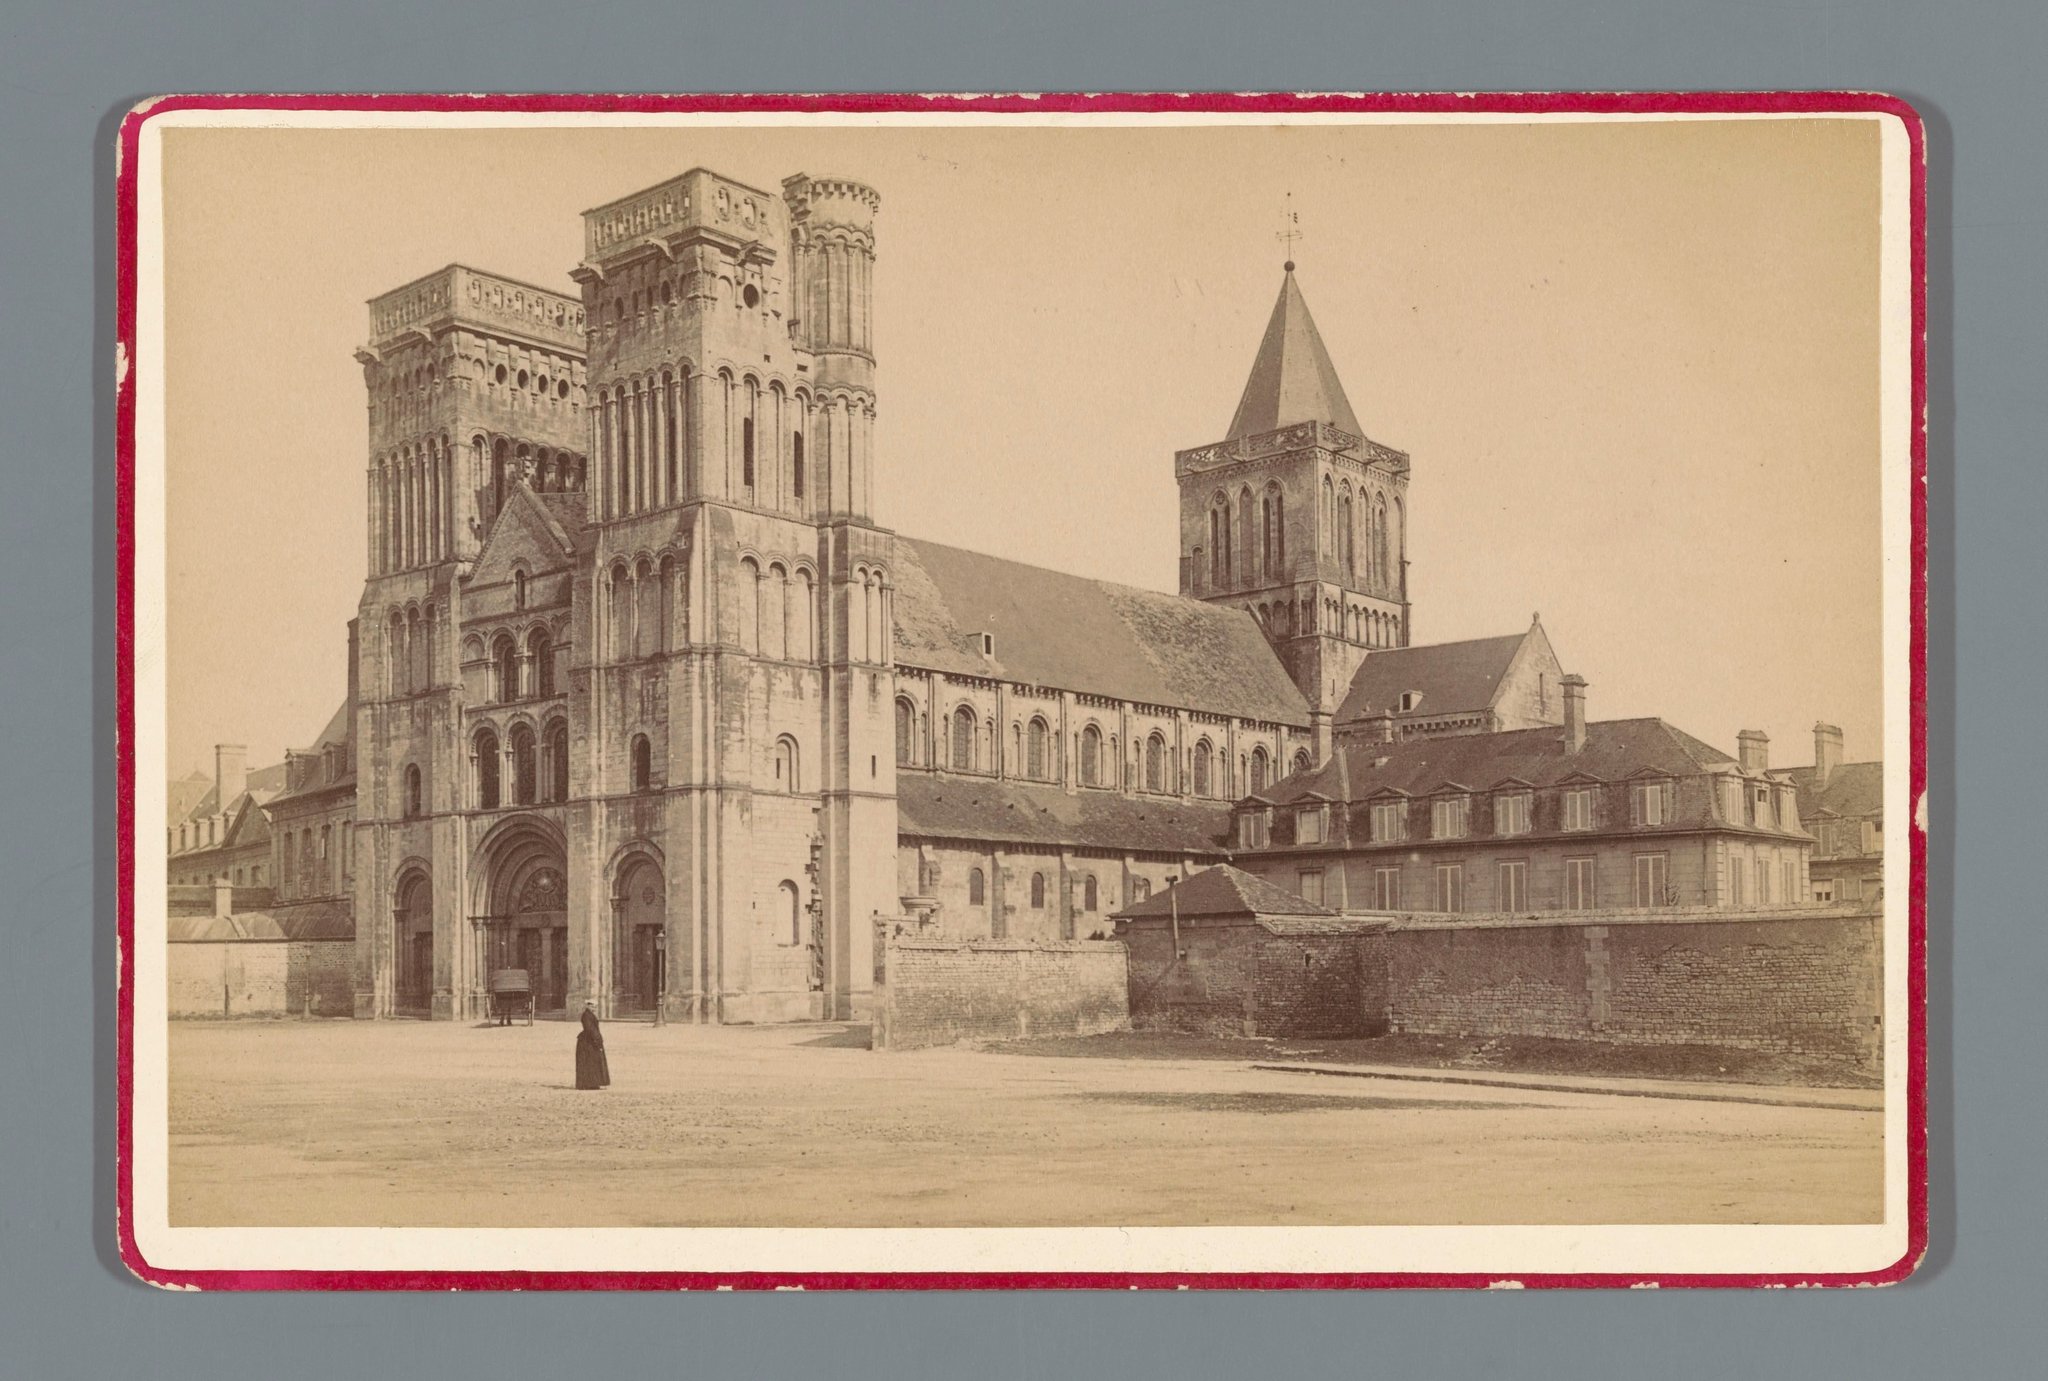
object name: cabinet photograph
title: Gezicht op de Abbaye aux Dames te Caen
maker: Anonymous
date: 1893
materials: cardboard, photographic support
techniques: albumen print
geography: caen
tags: façade (of house or building), monastic orders, monastic life ~ roman catholic church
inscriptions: date: ‘13 Août 1893’, annotation: ‘Caen, Ste Trinite ou Abbaye aux Dames’